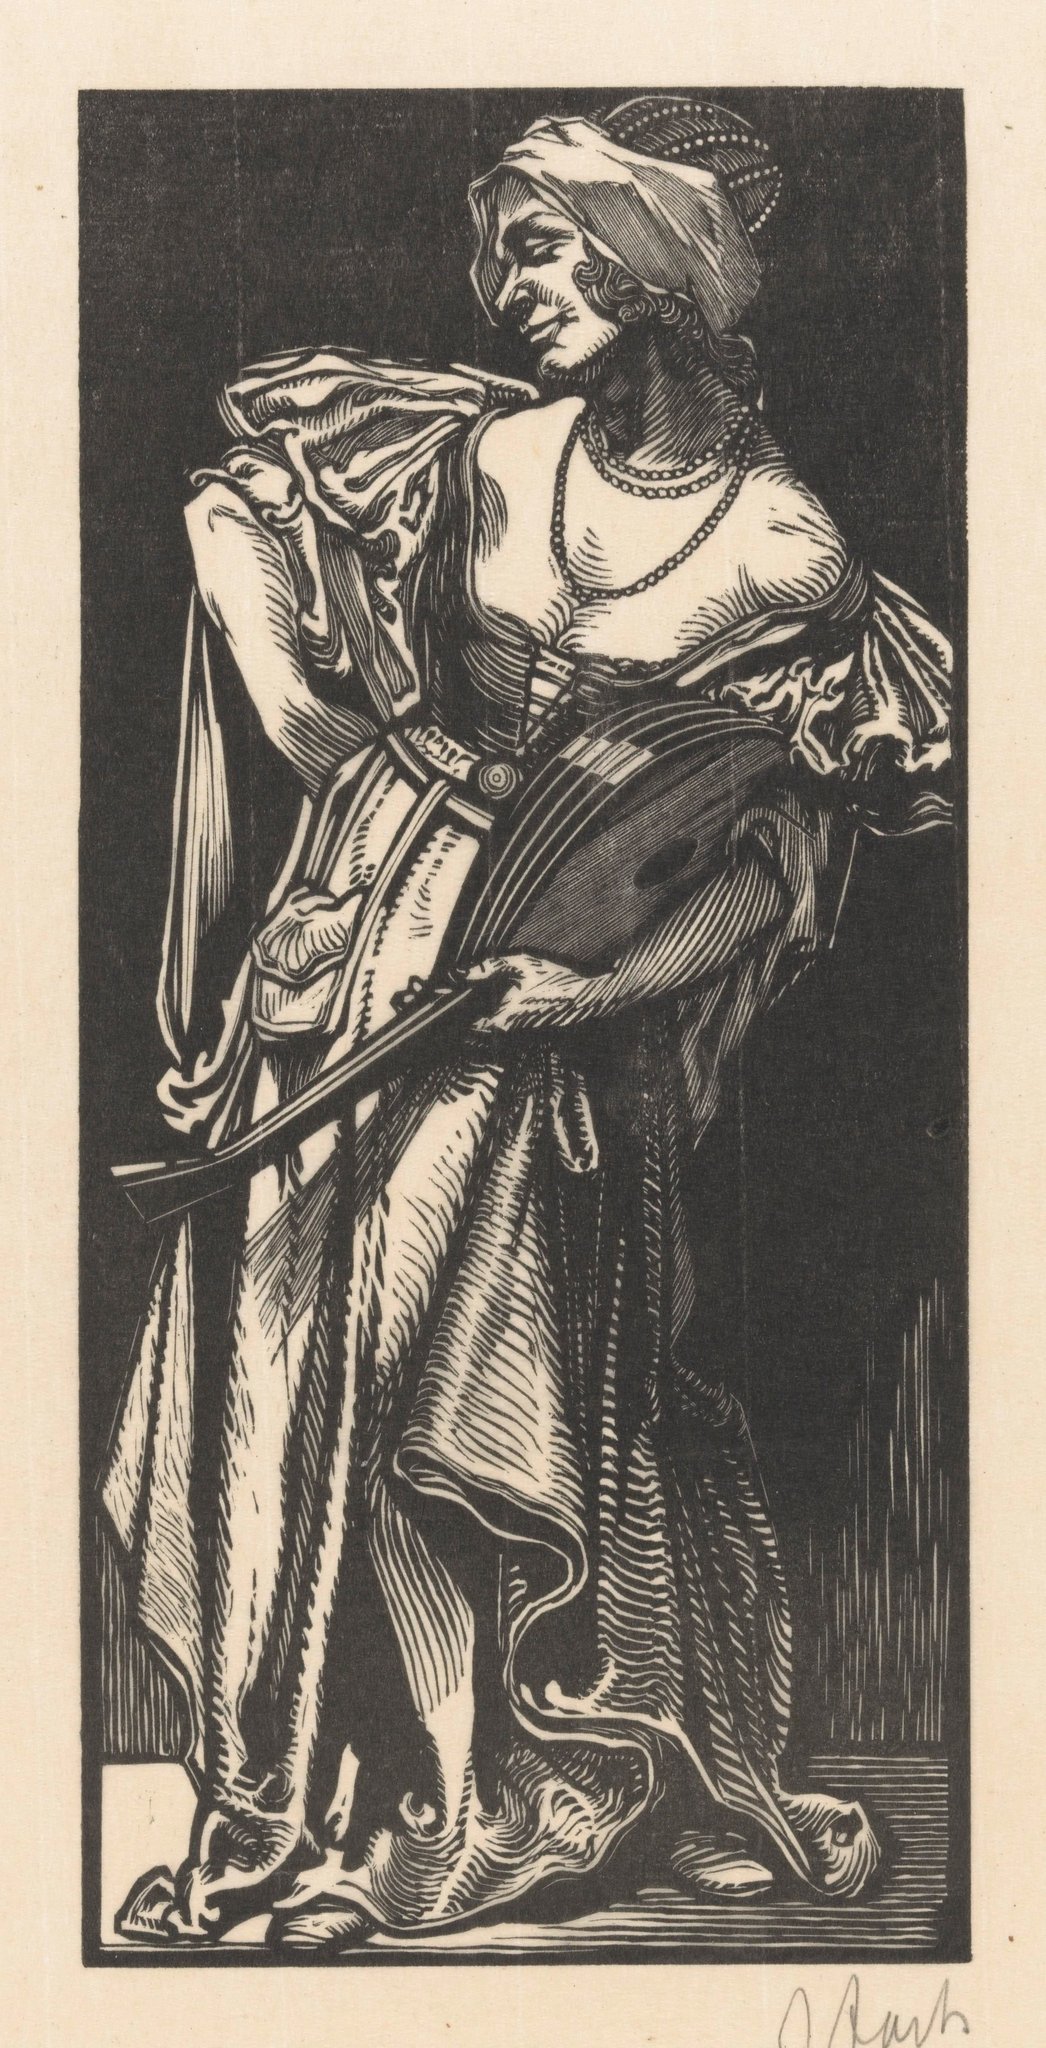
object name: print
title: Vrouw met luit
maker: johannes josephus aarts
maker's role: draughtsman, print maker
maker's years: 1871-1934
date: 1881-1931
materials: paper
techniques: woodcut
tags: musician, lute, and special forms of lute, e.g.: theorbo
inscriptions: collector's mark: Lugt 2228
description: Staande vrouw in jurk met in haar linkerhand een luit.